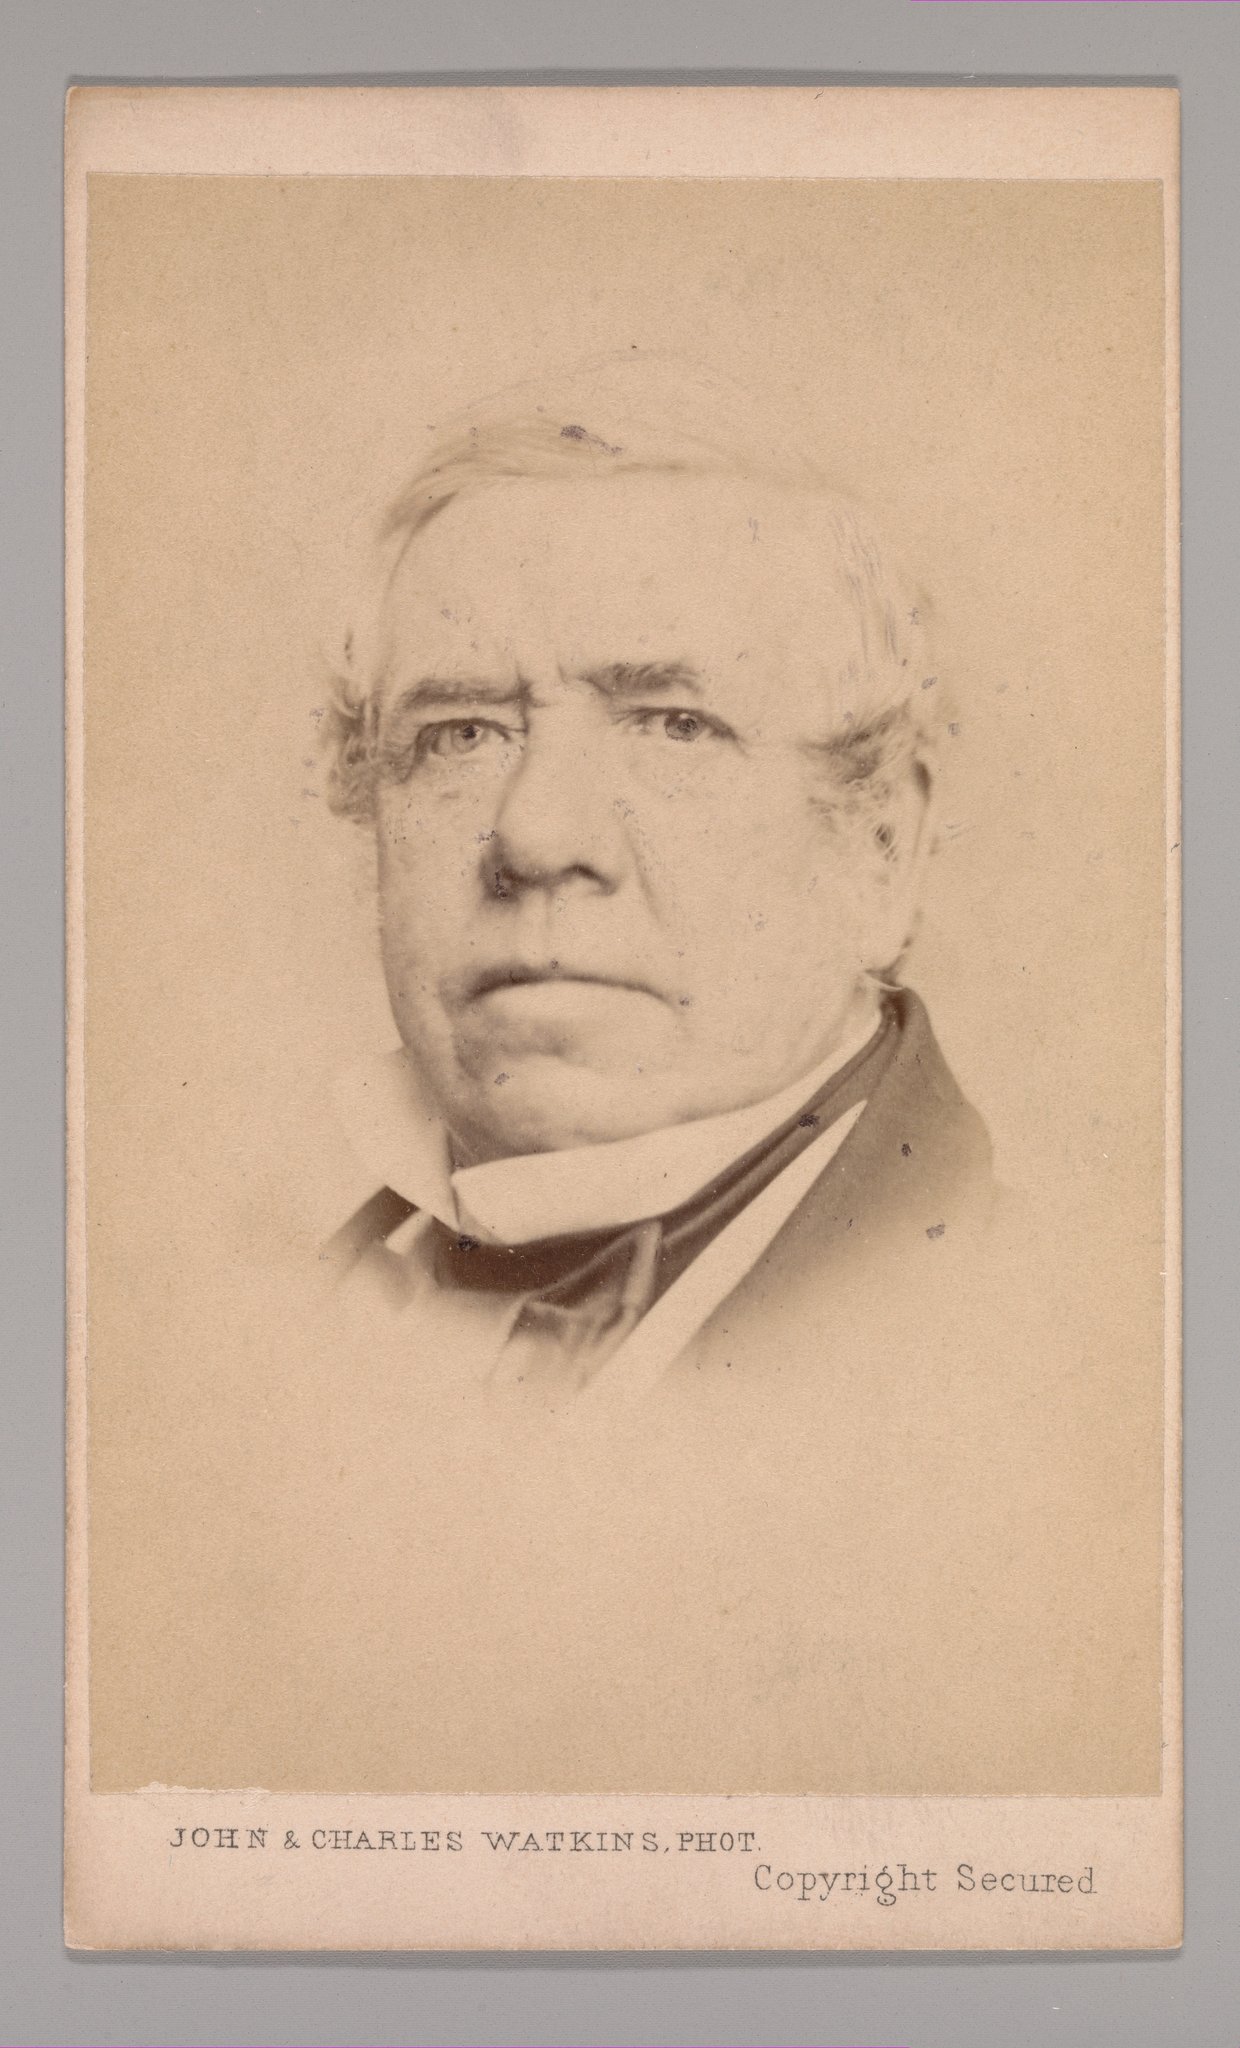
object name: carte de visite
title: [David Roberts]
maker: john and charles watkins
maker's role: photography studio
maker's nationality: british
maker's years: 1840-1875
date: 1860-1869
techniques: albumen silver print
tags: men,portraits